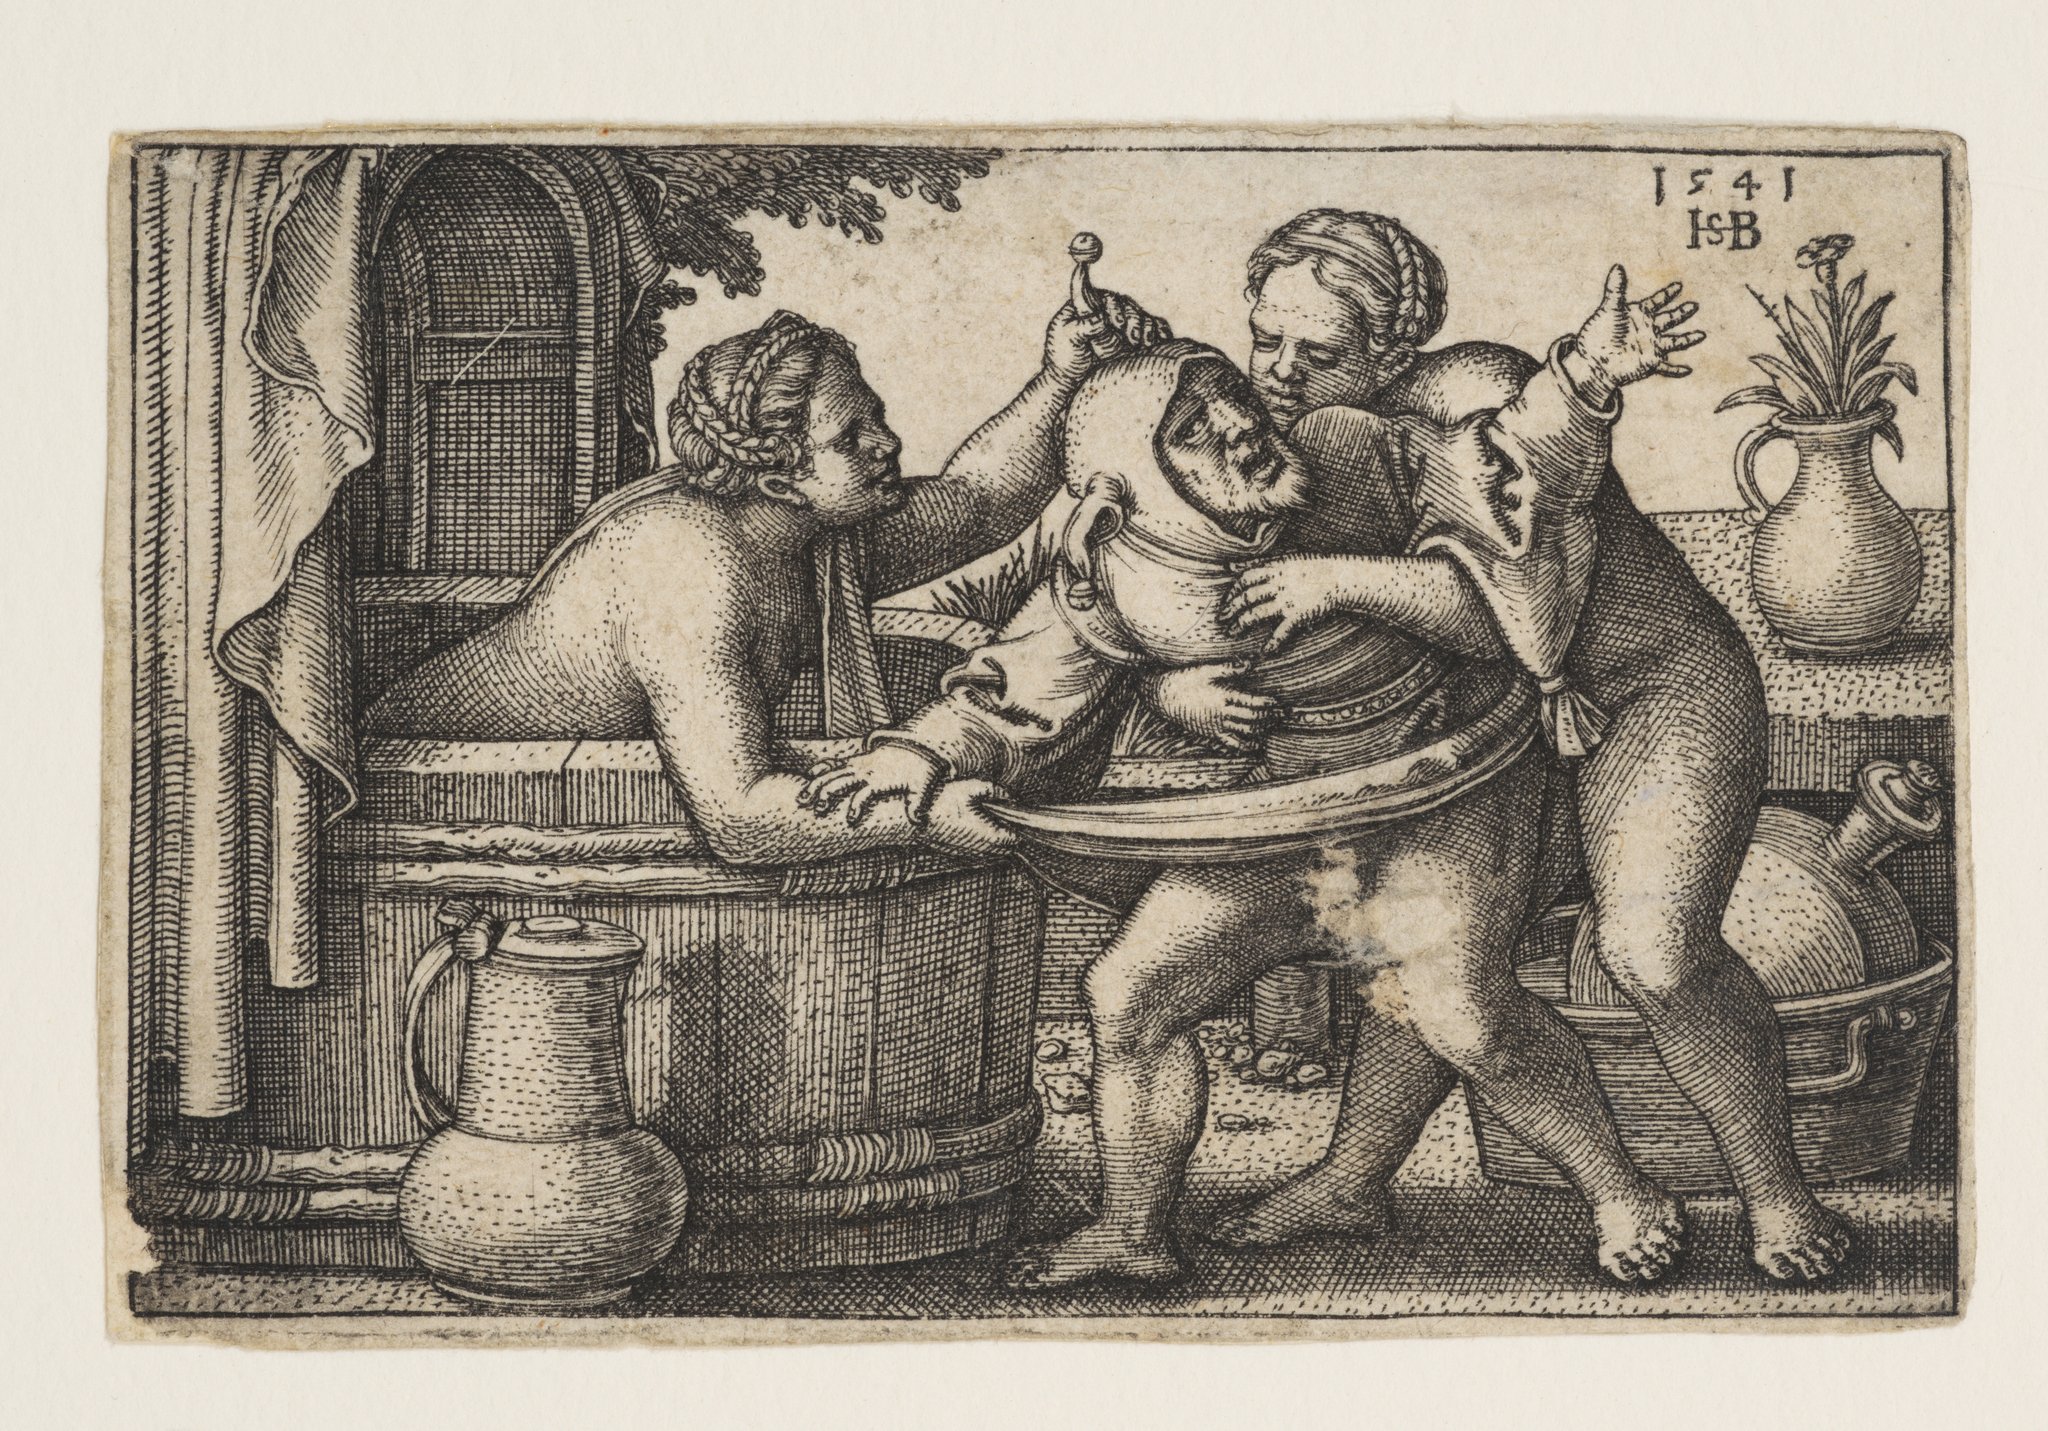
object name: print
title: Buffoon and the Two Bathing Women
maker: sebald beham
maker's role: artist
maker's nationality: german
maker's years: 1500-1550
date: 1541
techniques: engraving